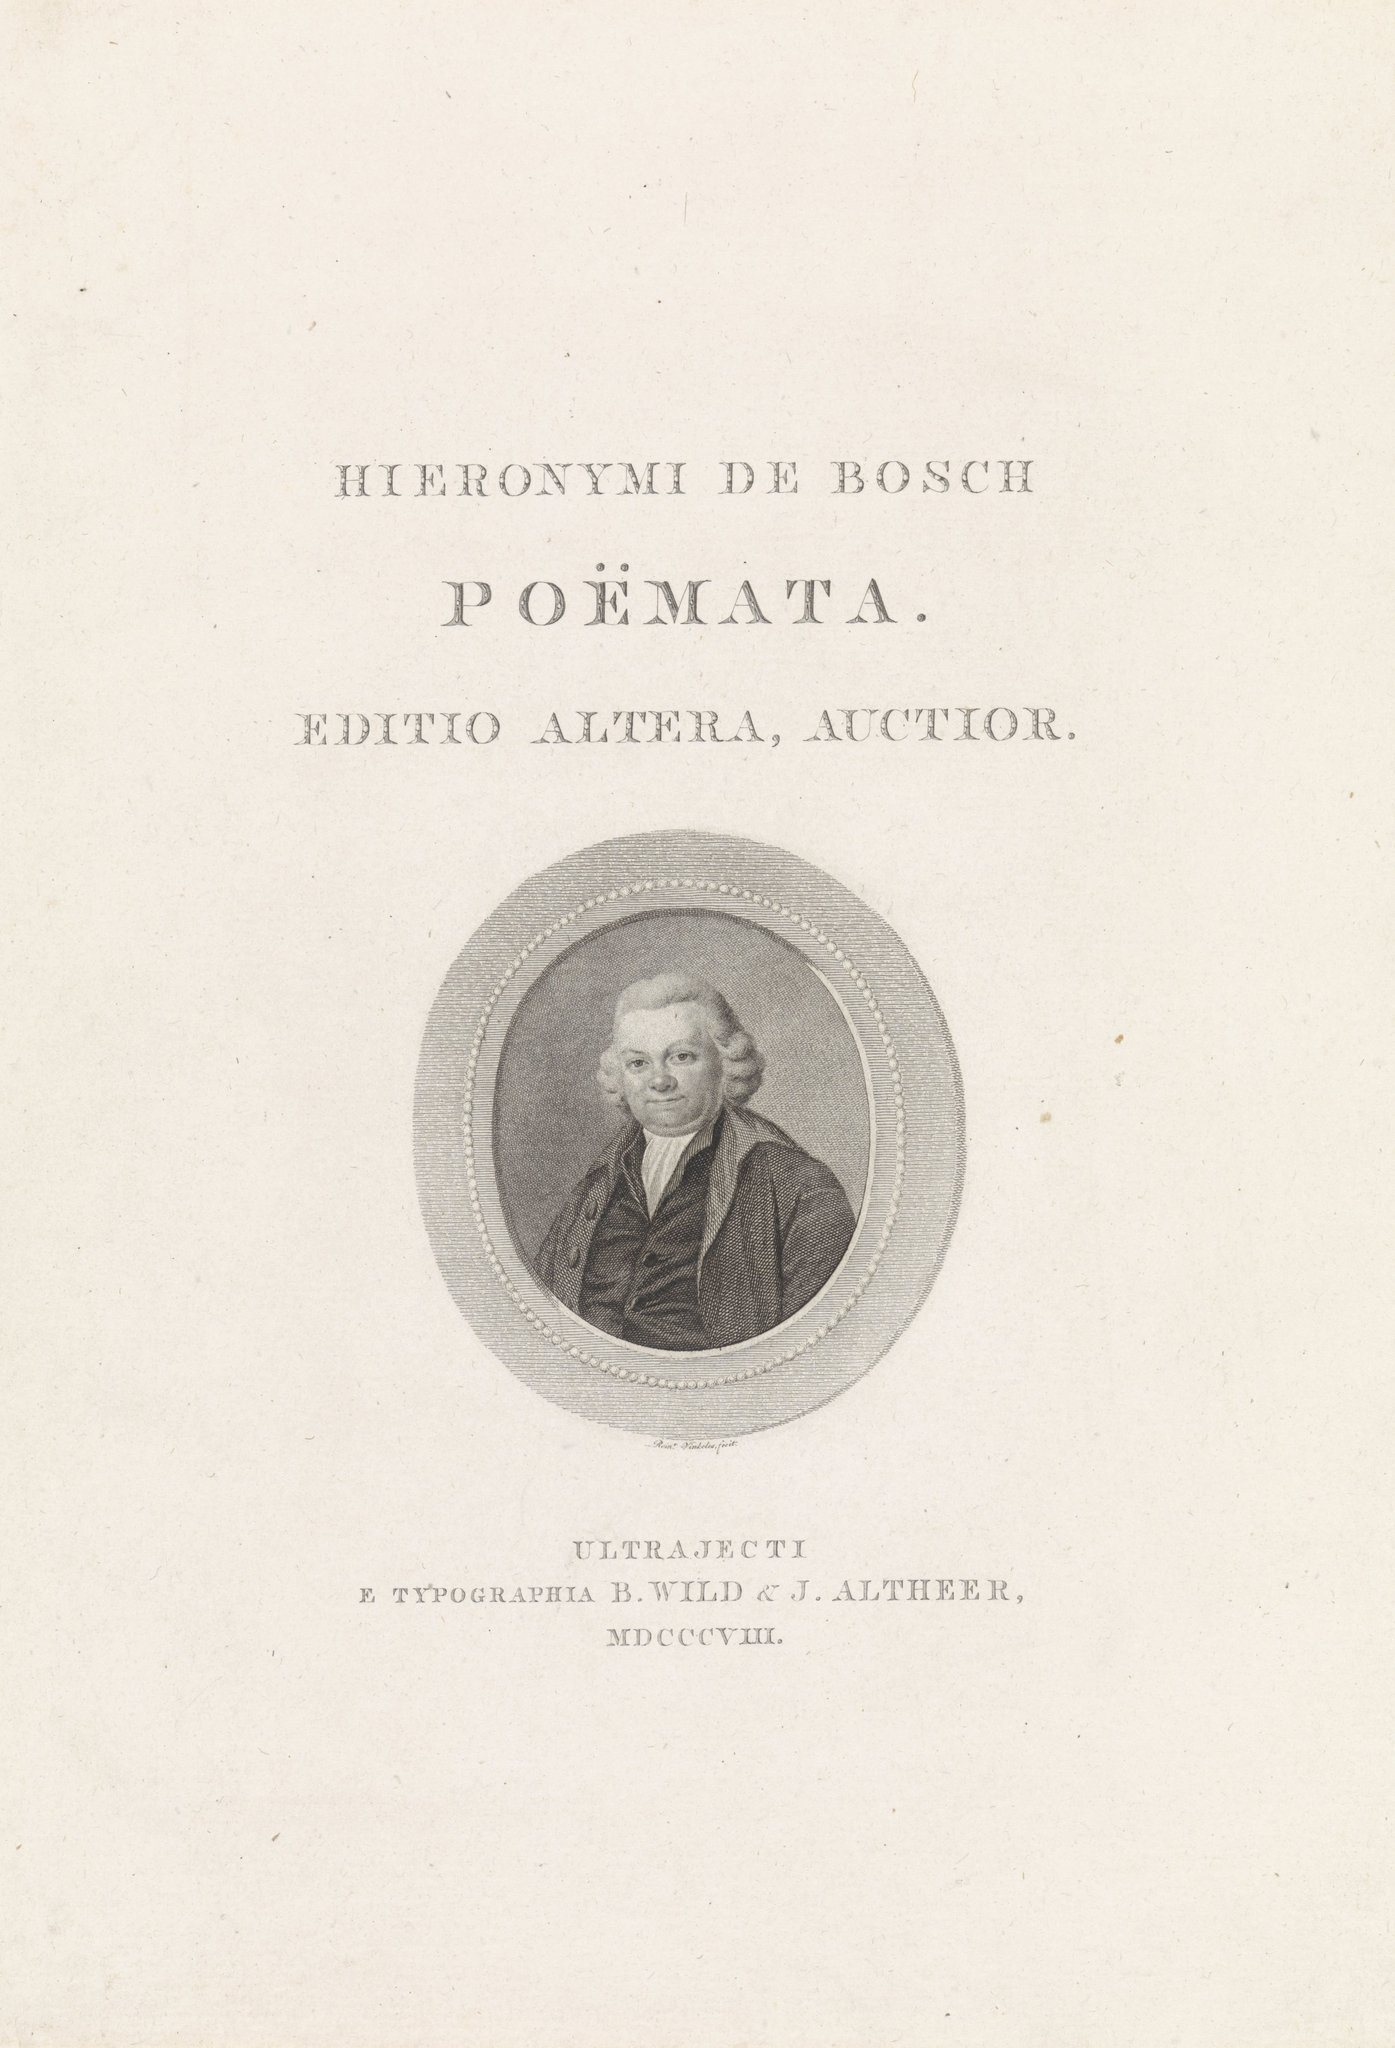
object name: titelblad, titelpagina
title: Titelpagina voor: Bosch, J. de, Poëmata, 1808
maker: reinier vinkeles (i)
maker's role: draughtsman, print maker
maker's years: 1741-1816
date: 1808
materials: paper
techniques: etching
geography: utrecht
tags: amsterdam, jeronimo de bosch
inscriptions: collector's mark: Lugt 2228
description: Titelpagina voor: Bosch, Jeronimo de. Poëmata editio altera auctor. Utrecht: B. Wild en J. Altheer, 1808.